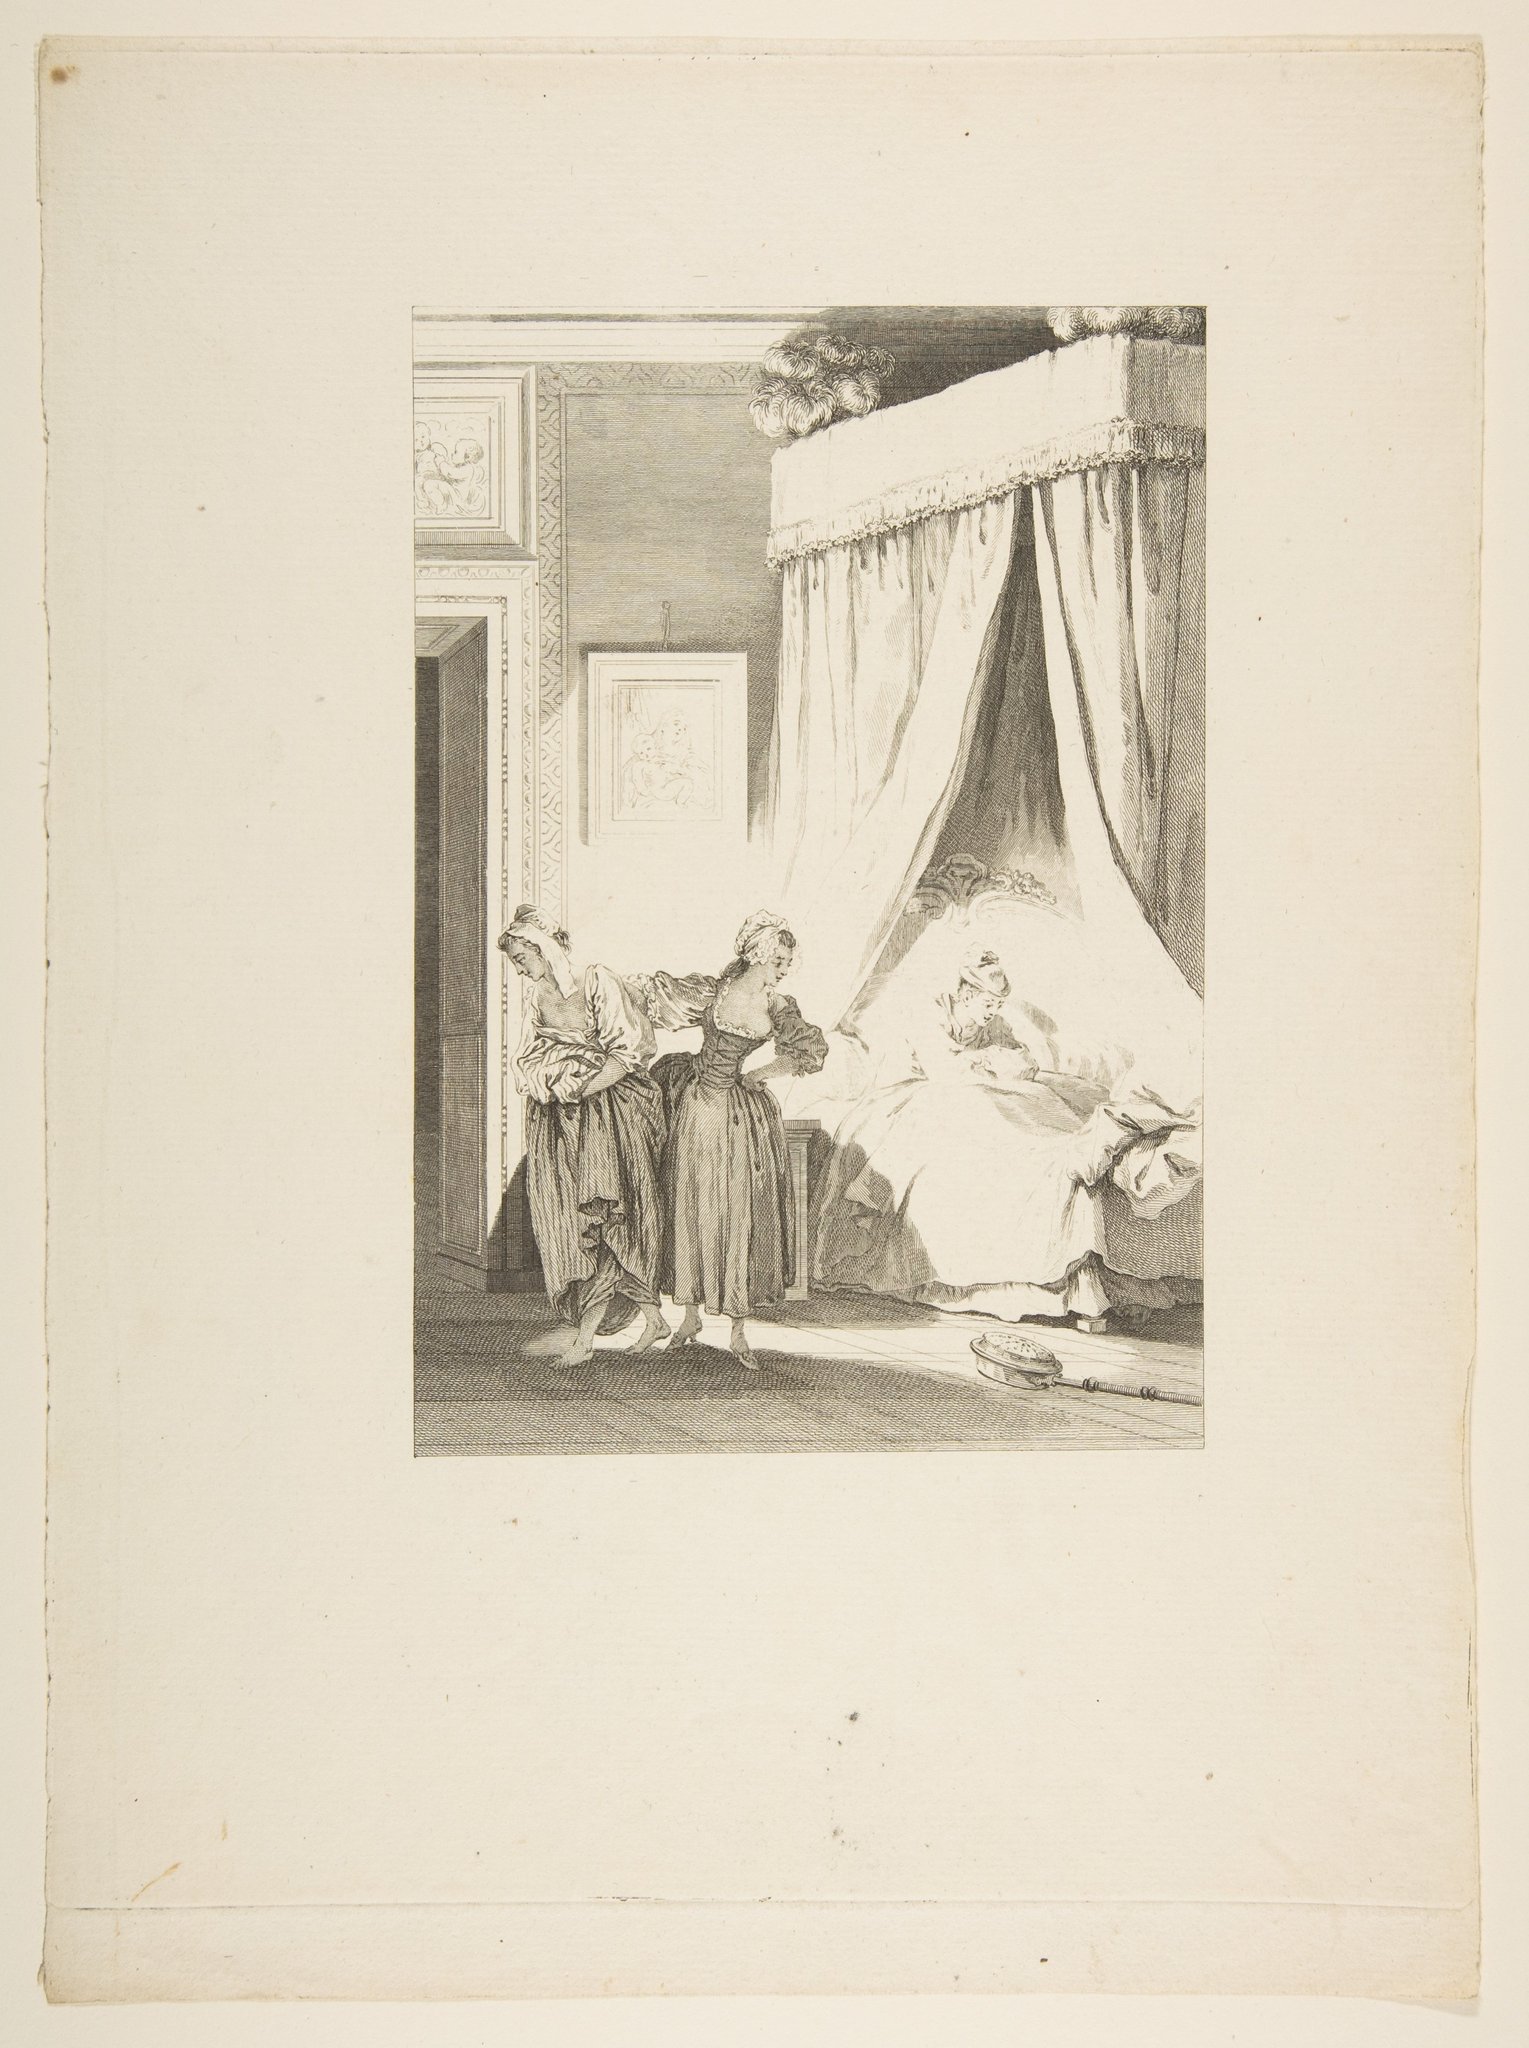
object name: print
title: La Gageure des trois Commeres: La Servante, from "Contes et nouvelles en vers par Jean de La Fontaine. A Paris, de l'imprimerie de P. Didot, l'an III de la République, 1795"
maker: philippe trière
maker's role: artist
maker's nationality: french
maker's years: 1756-1815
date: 1795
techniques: etching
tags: bedrooms,women,servants